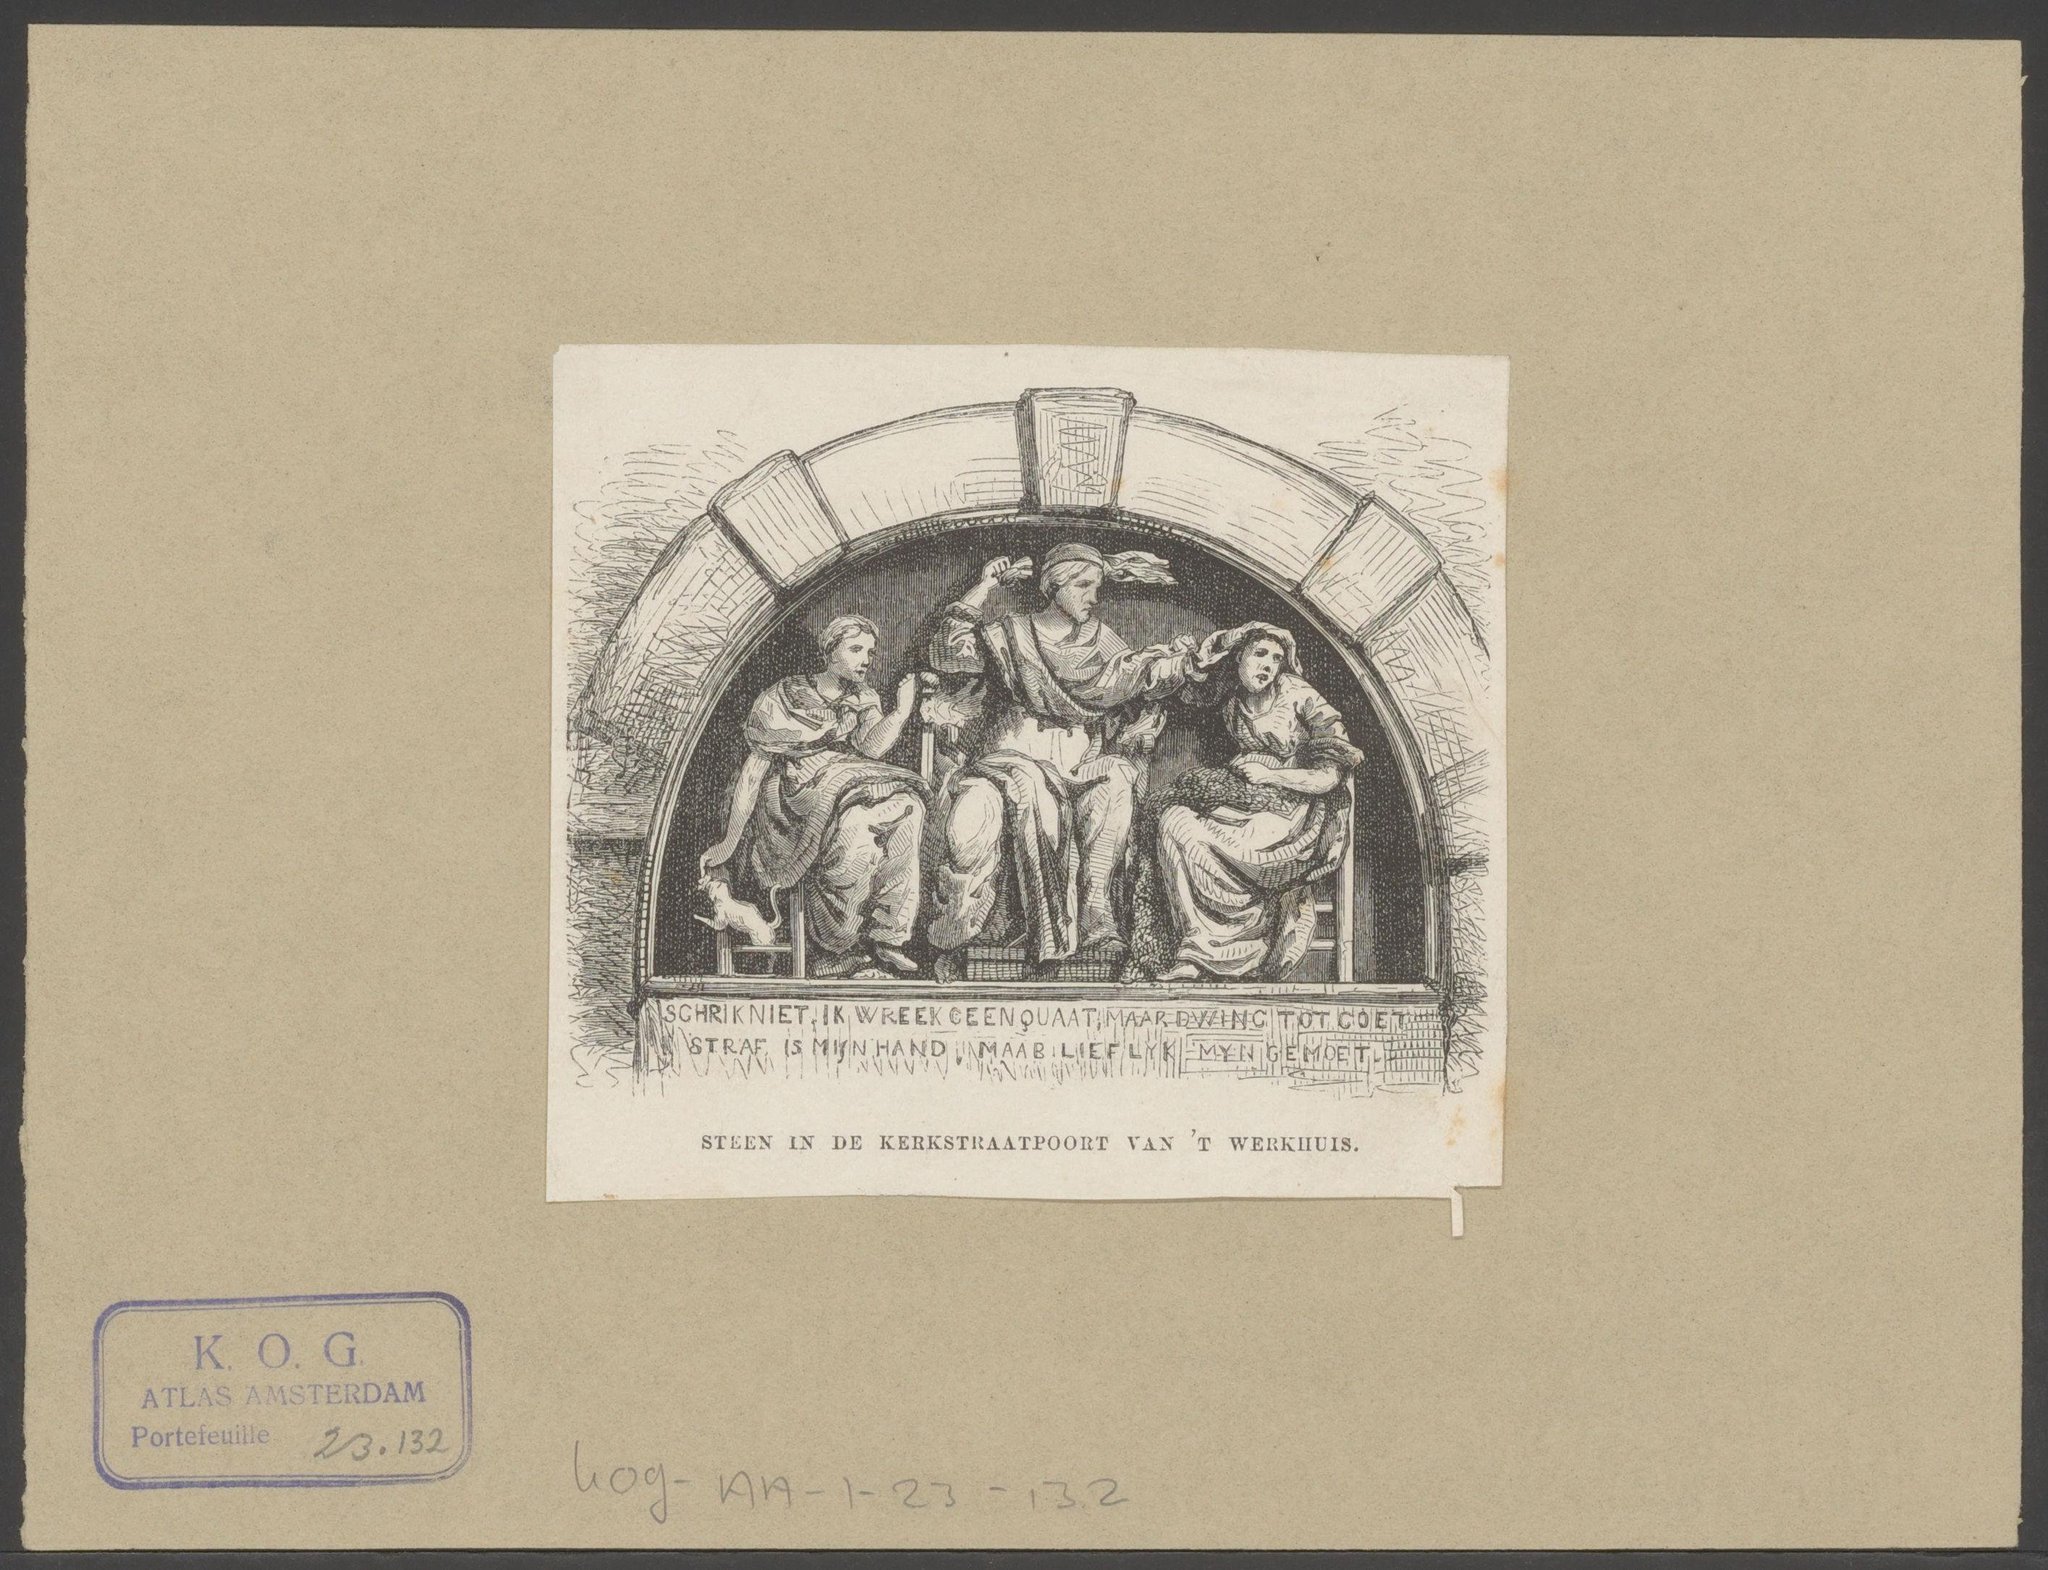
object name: print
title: Beeldhouwwerk boven de poort van het Nieuwe Werkhuis te Amsterdam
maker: Anonymous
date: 1860-1880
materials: paper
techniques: engraving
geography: netherlands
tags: gate, entrance, sculpture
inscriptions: collector's mark: Lugt 1641b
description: Onderwerpsrubriek binnen de Atlas Amsterdam: Rechtswezen.